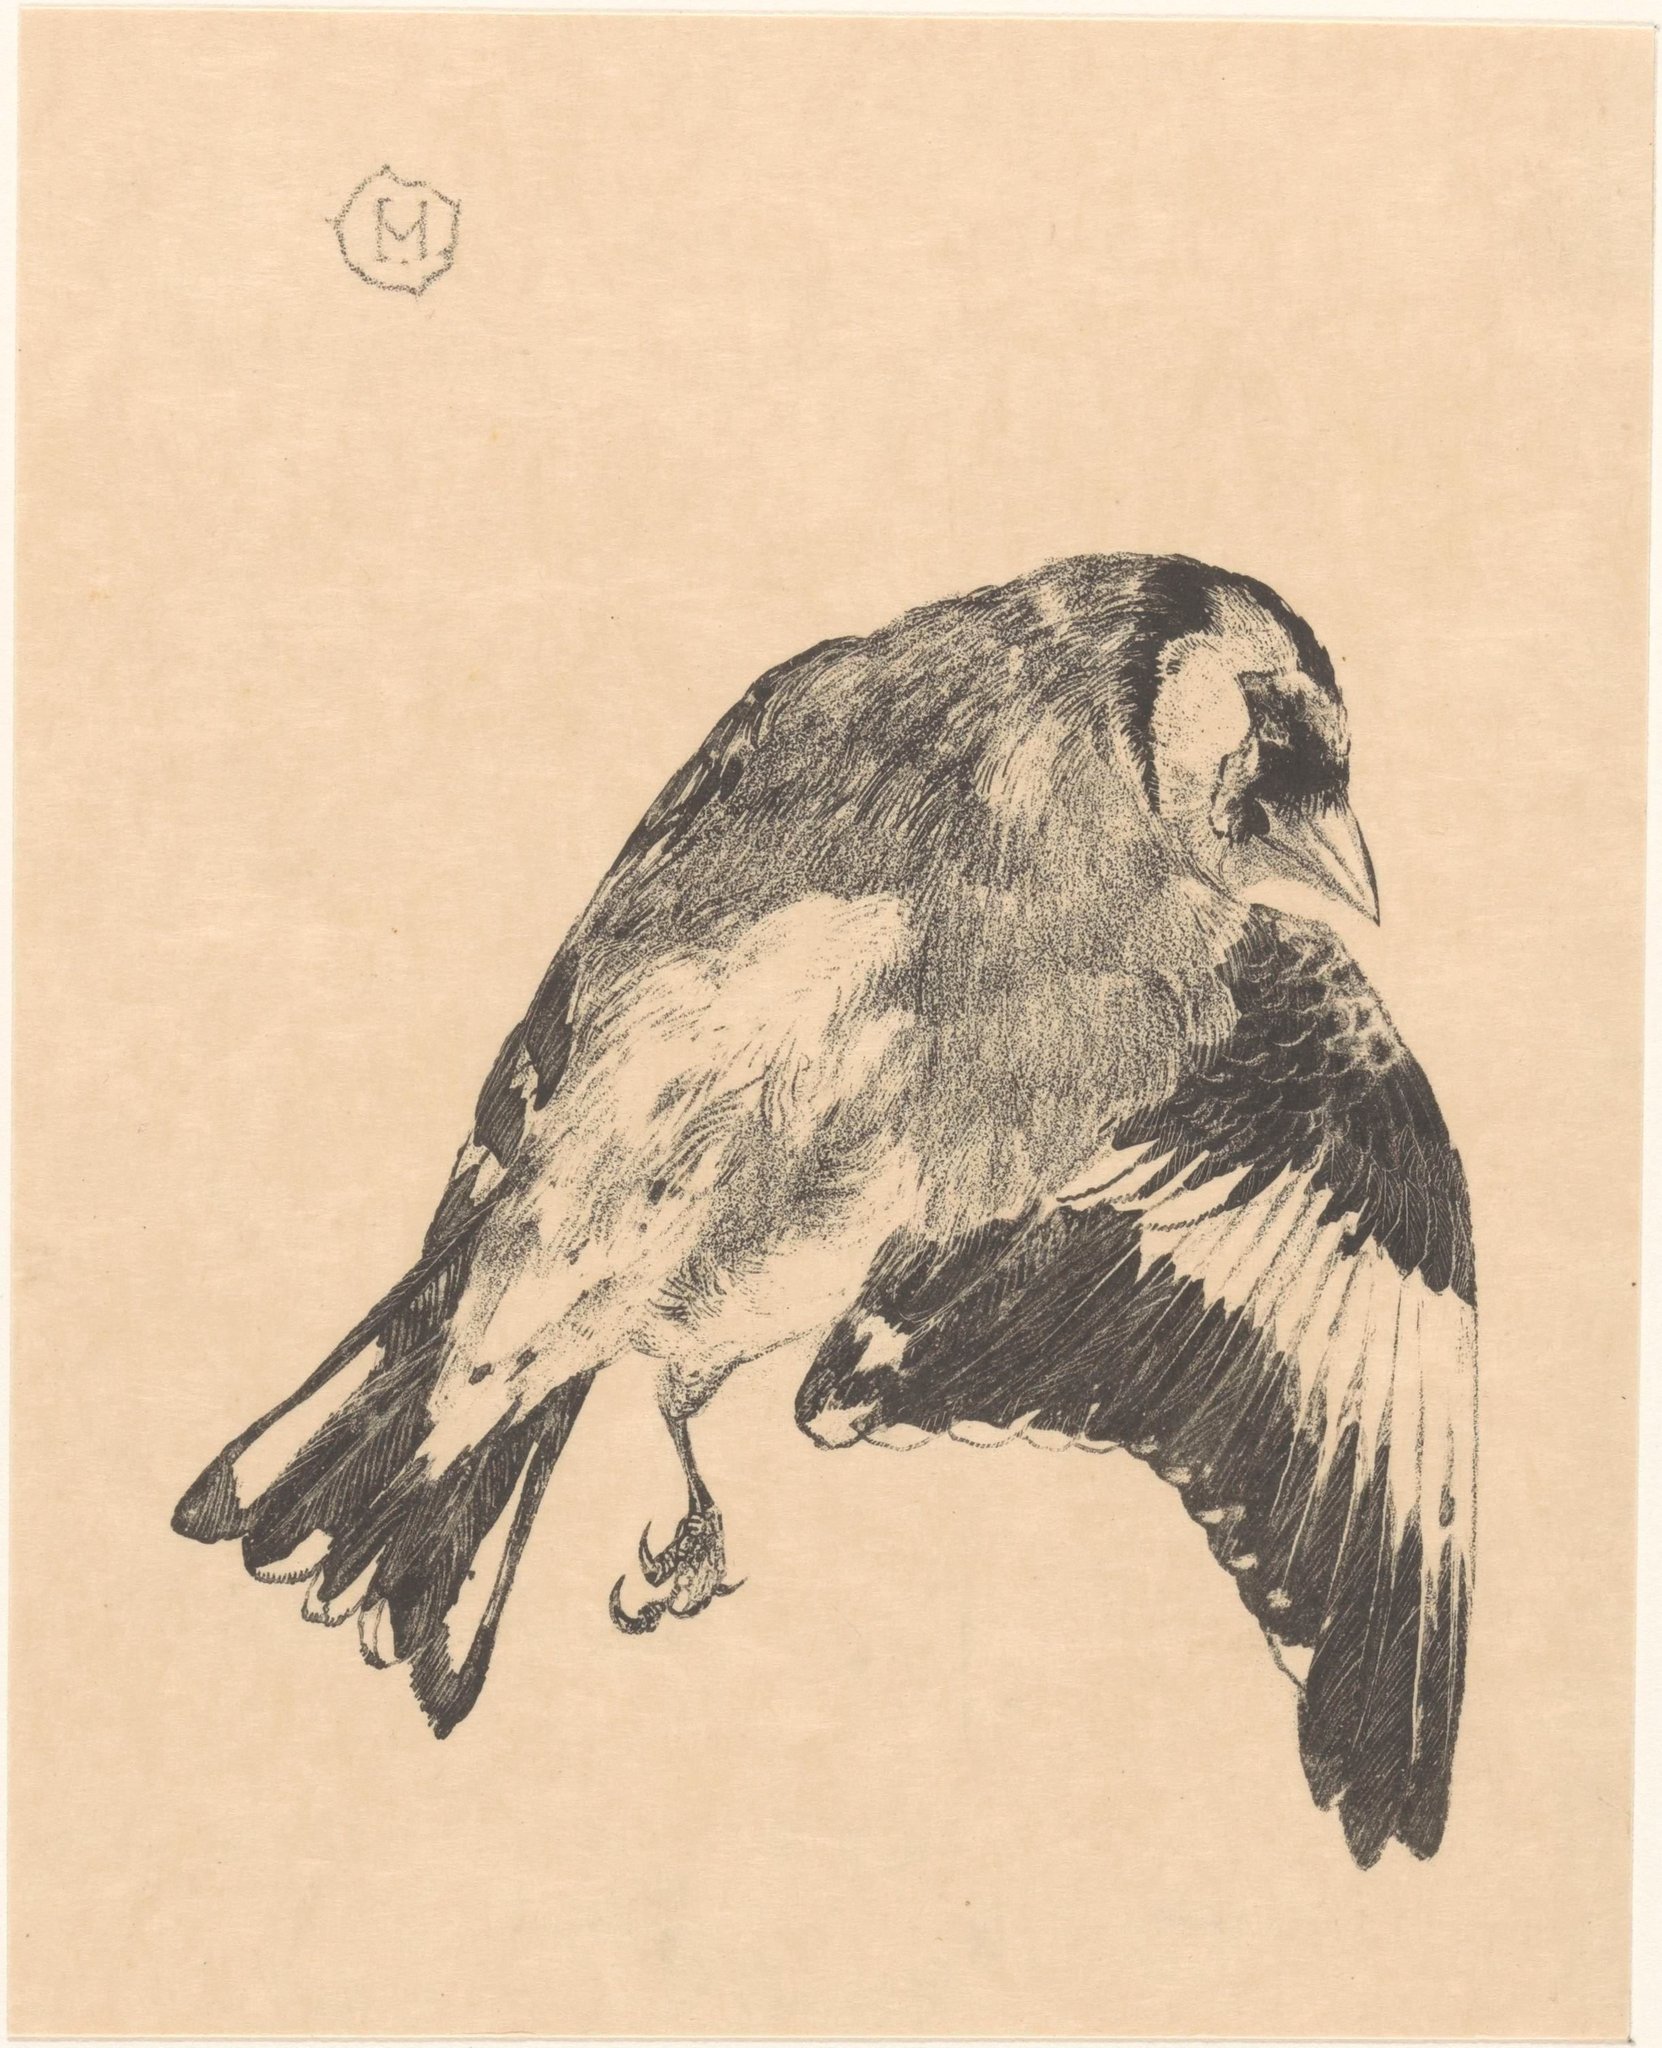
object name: print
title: Dood puttertje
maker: theo van hoytema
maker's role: draughtsman, painter, print maker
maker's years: 1863-1917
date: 1878-1914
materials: paper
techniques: lithograph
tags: birds (+ dying animal; death of animal; dead animal), song-birds: goldfinch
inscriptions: collector's mark: Lugt 2233